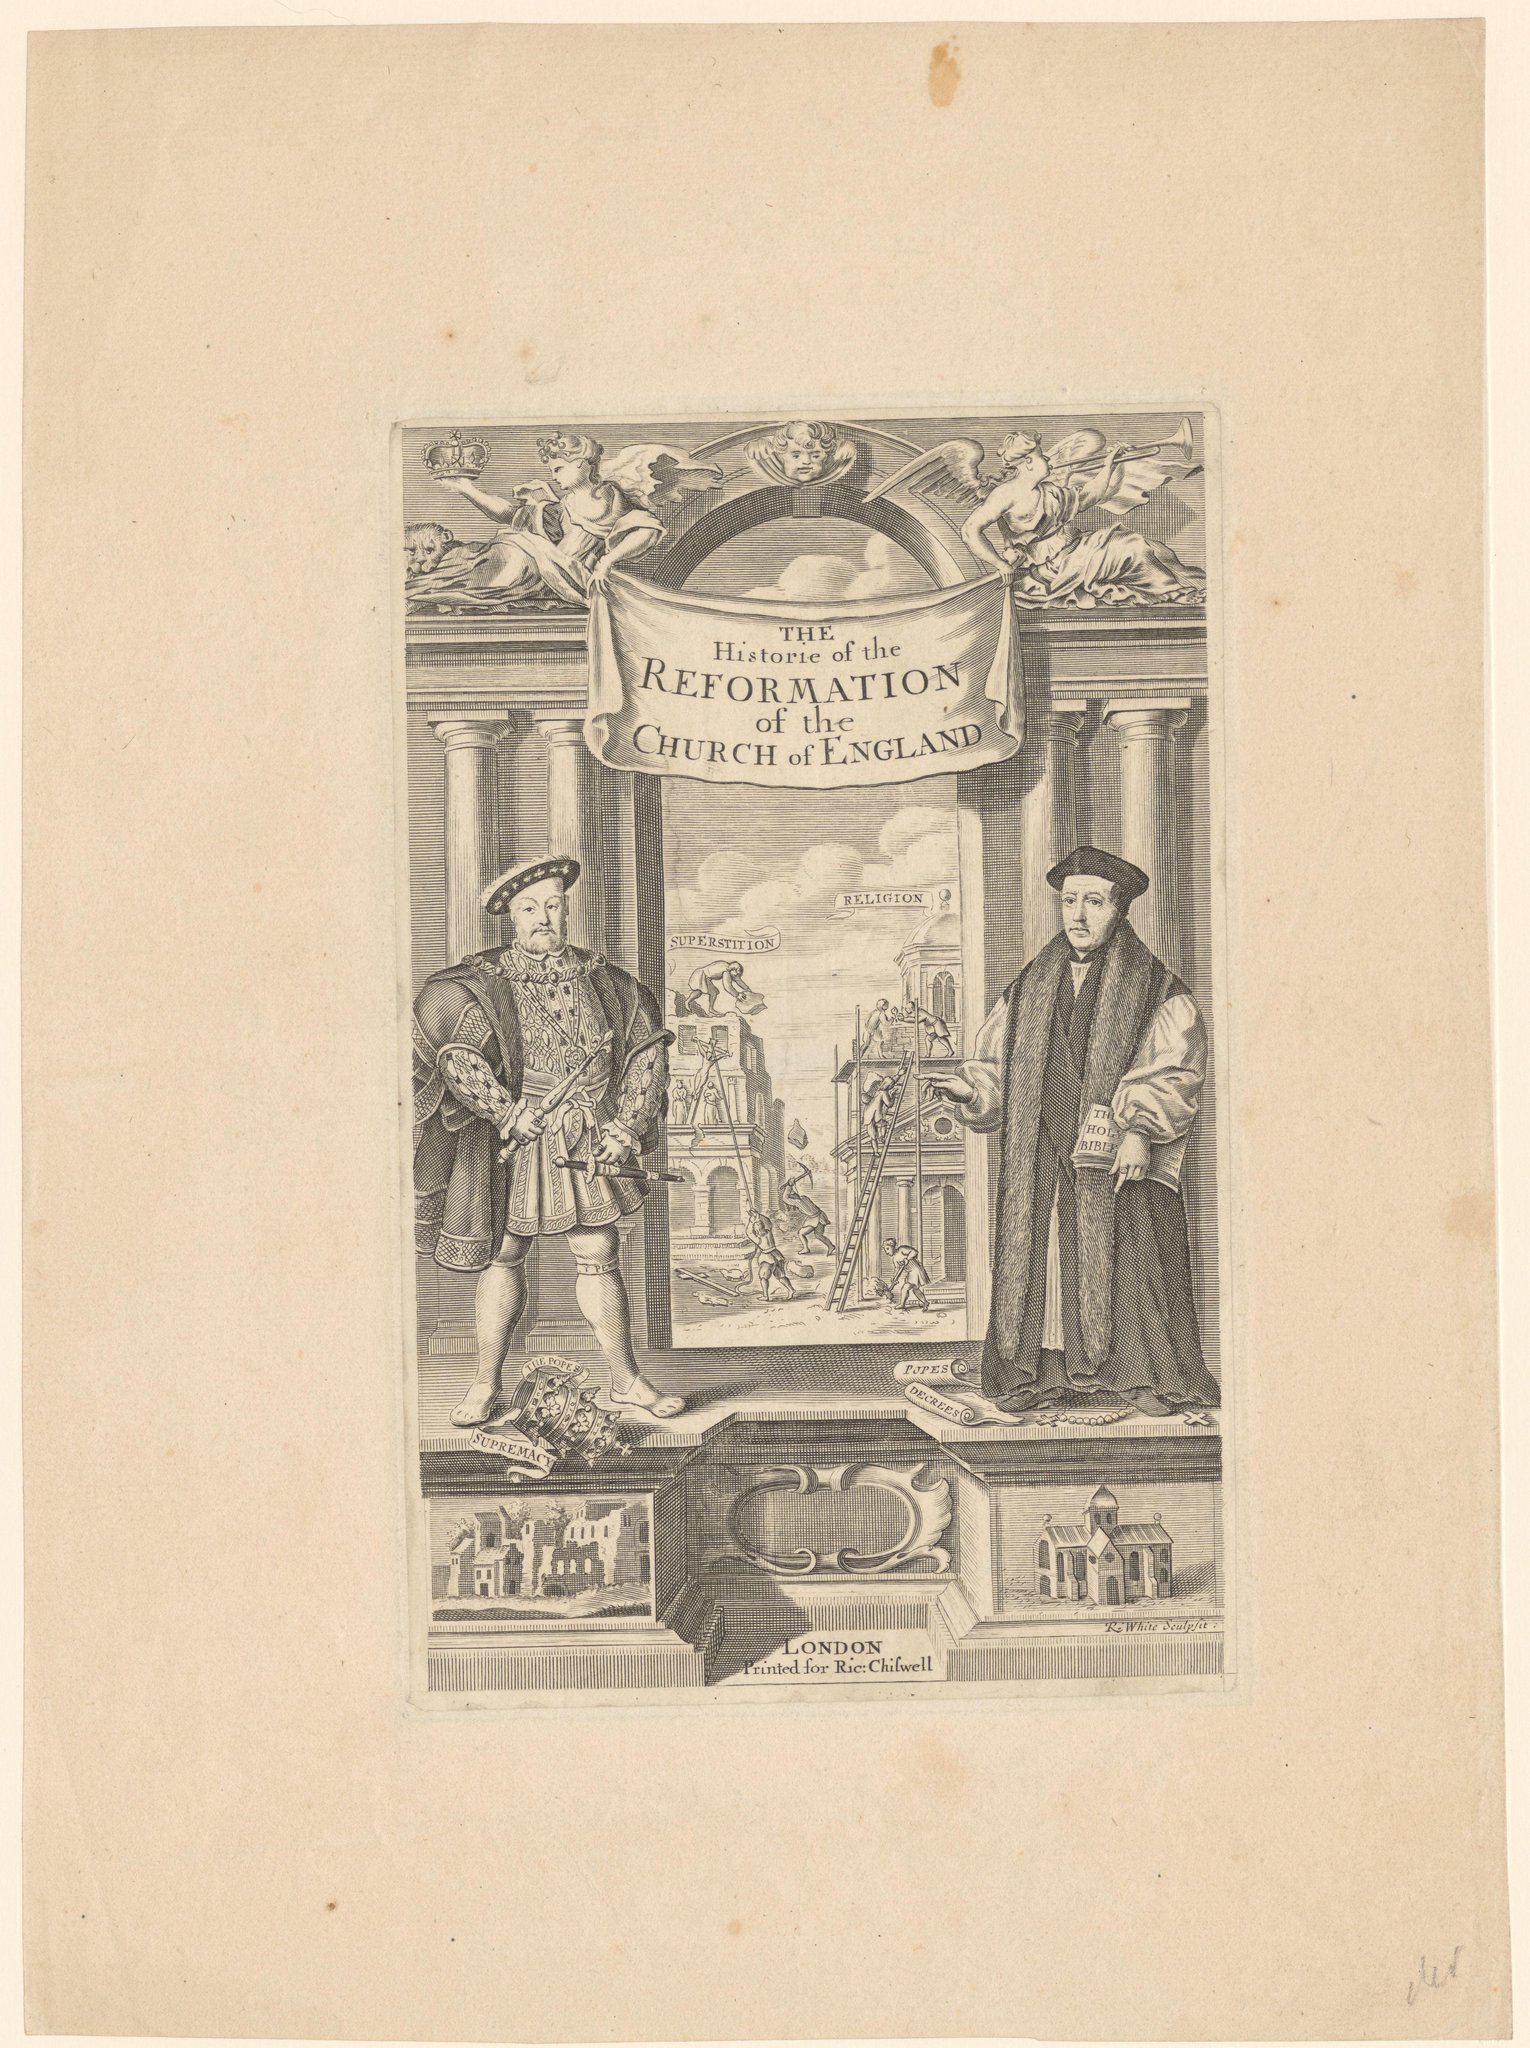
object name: print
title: Titelpagina voor: Gilbert Burnet, The Historie of the Reformation of the Church of England, 1681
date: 1679-1681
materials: paper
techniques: engraving, etching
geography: london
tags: non-roman catholic episcopal churches, e.g. anglicans, historical persons, building-site, iconoclasm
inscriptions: collector's mark: Lugt 2228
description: Hendrik VIII van Engeland en de anglicaanse aartsbisschop Thomas Cranmer staan aan beide zijden van een poort. Bij hun voeten liggen een pauselijke kroon, een rozenkrans en papieren waarop staat 'popes' en 'decrees'. Door de poort zijn links mensen onder een banderol met 'superstition' bezig met het afbreken van een kerk en het neerhalen van een beeld met de kruisiging van Christus. Rechts, onder een banderol met 'Religion', wordt een kerk opgebouwd.